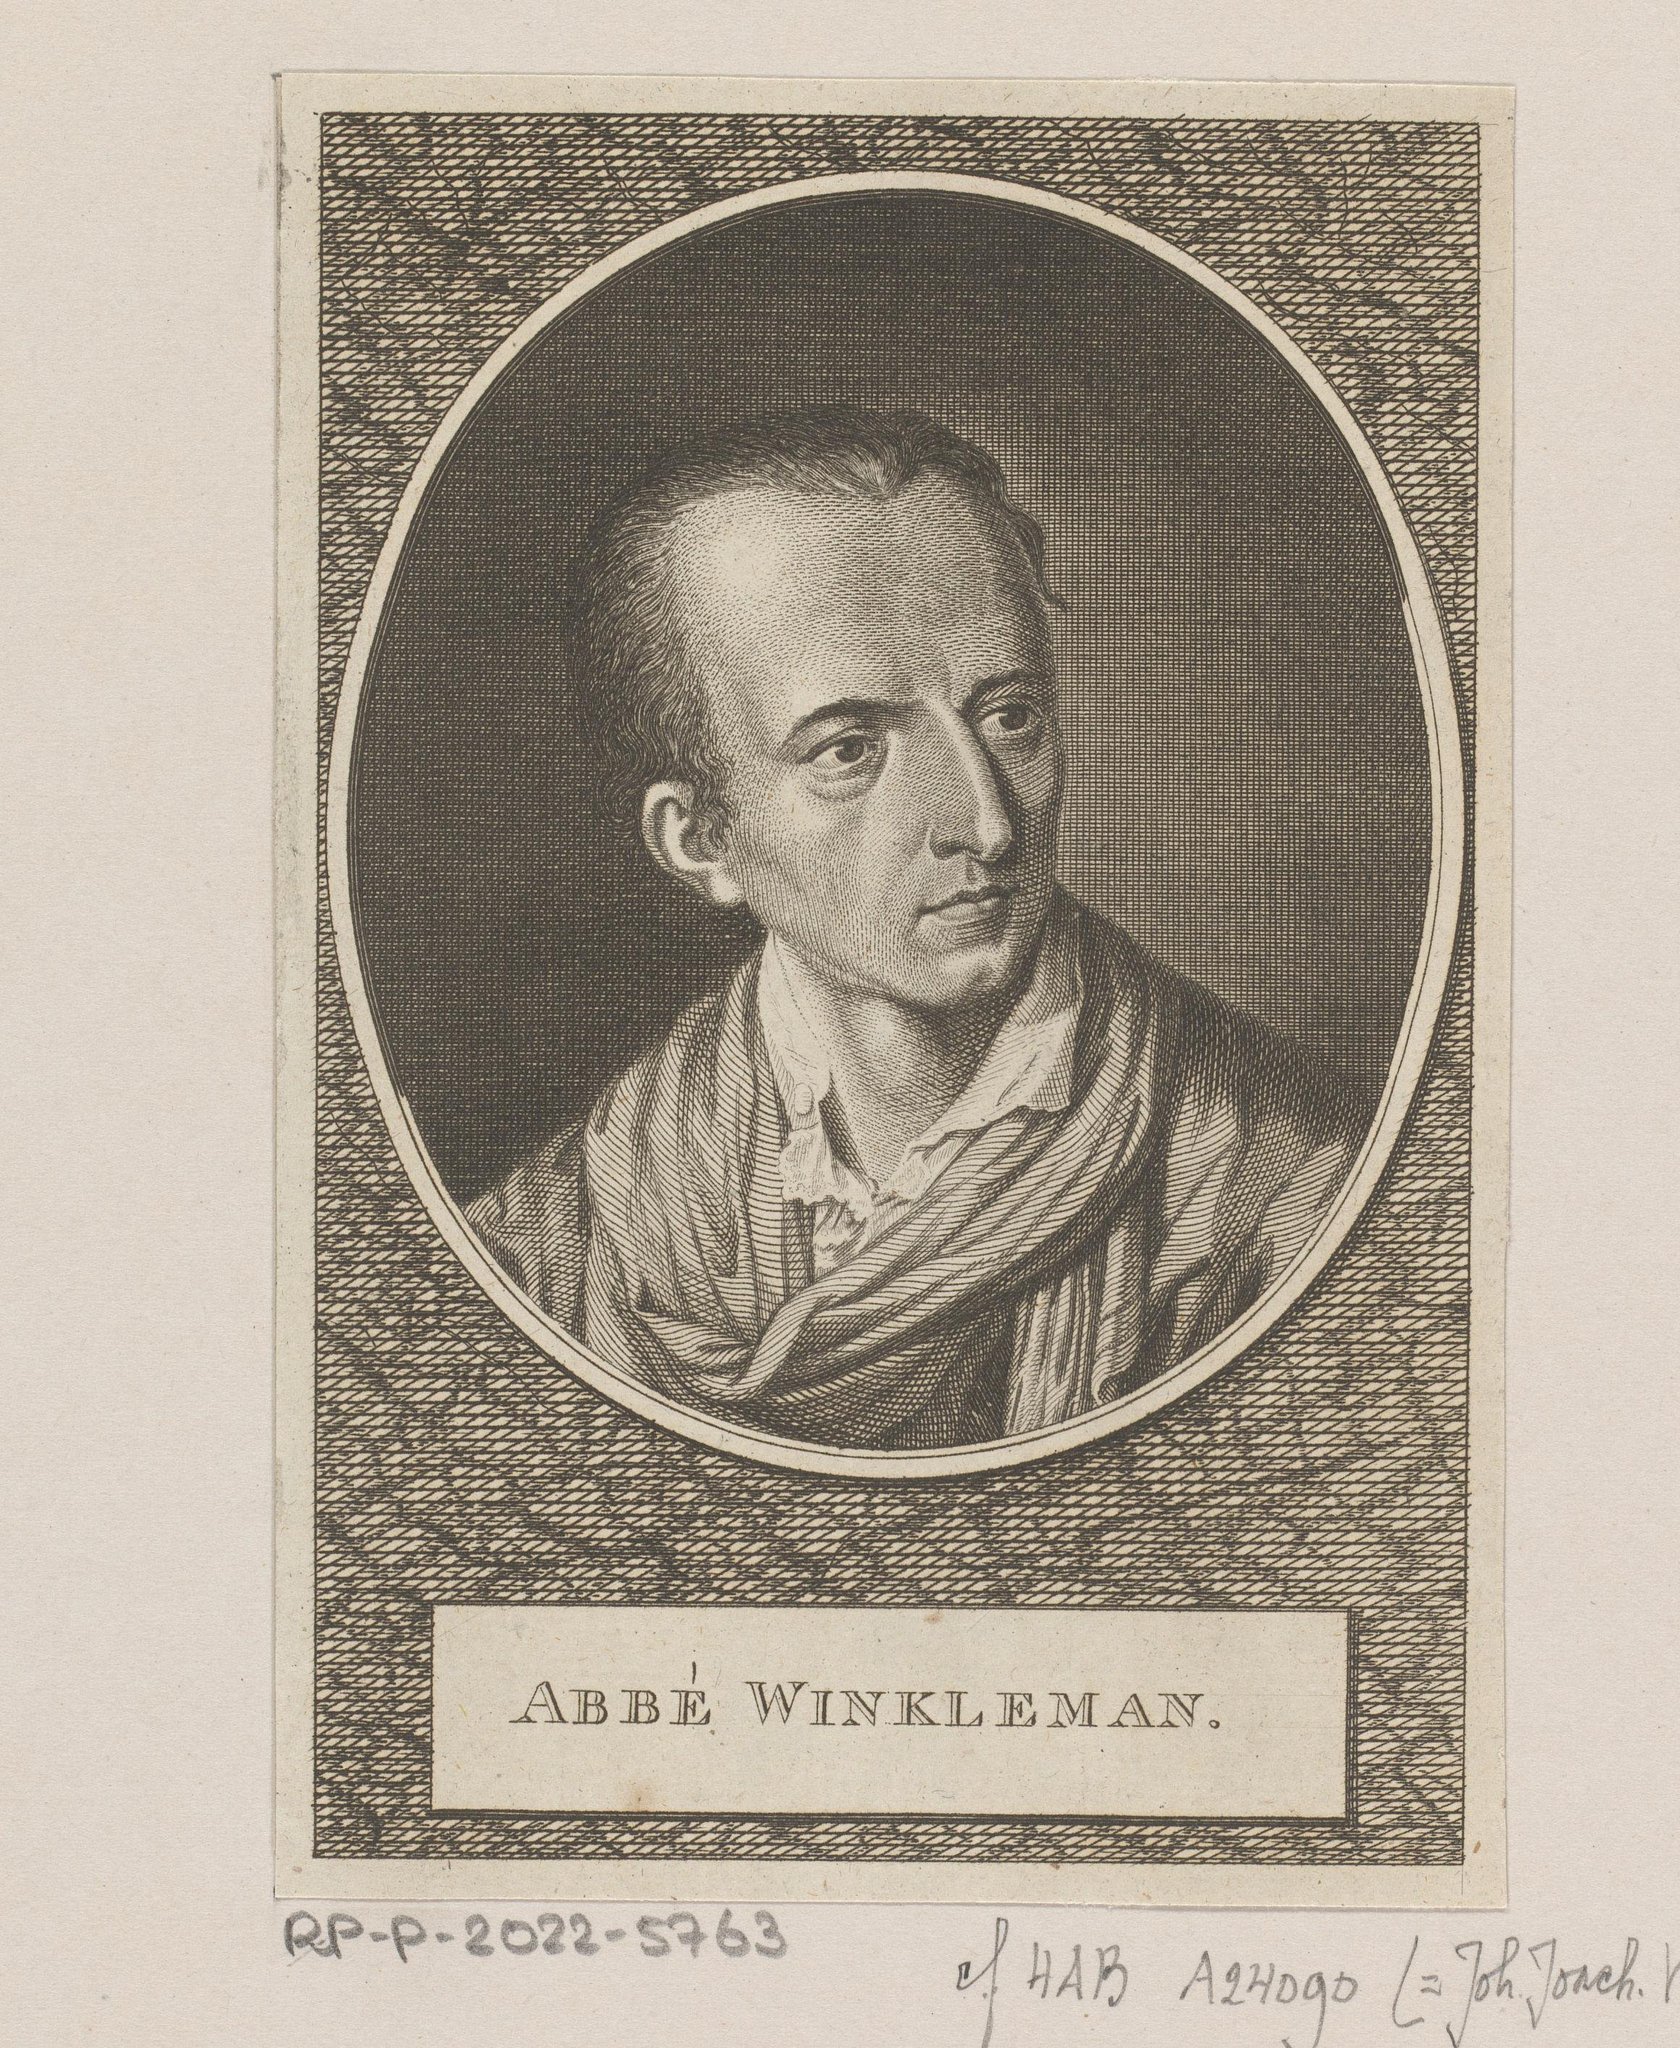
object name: print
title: Portret van Johann Joachim Winckelmann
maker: Anonymous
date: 1782-1802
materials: paper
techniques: engraving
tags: history of art (+ portrait of scholar, scientist), historical persons